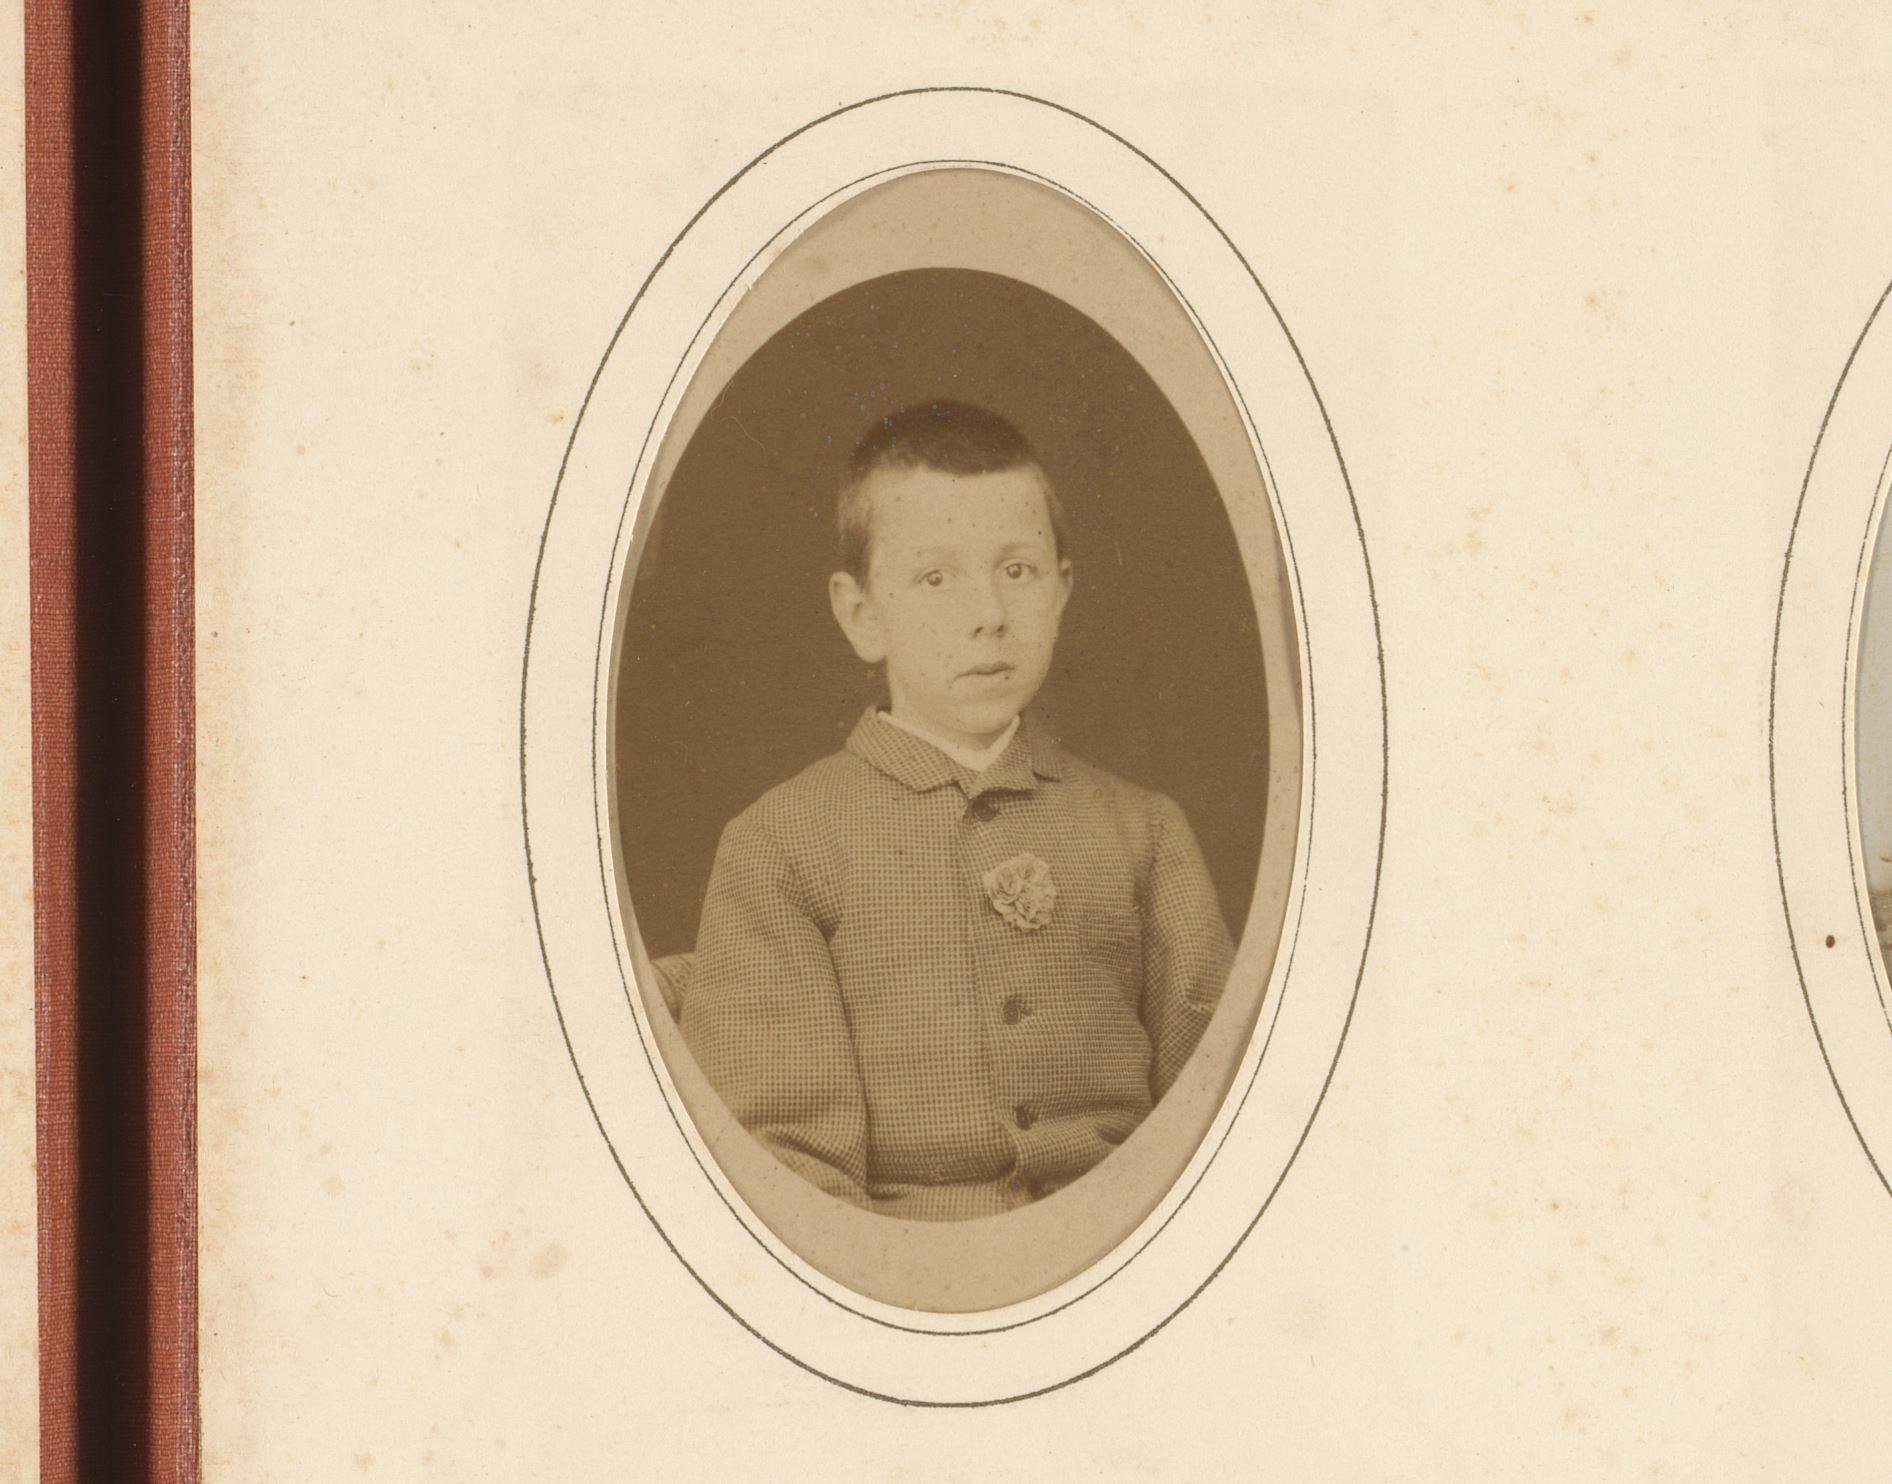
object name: photograph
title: Portret van een jongen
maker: lodewijk hendrikus serré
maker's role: fotograaf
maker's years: 1847-1897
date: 1877-1897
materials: cardboard, photographic support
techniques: albumen print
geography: utrecht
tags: boy (child between toddler and youth), historical persons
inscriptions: inscription: ‘L. H. SERRÉ/ PHOTOGRAPHE/ NACHTEGAALSTRAAT over het Park Tivoli/ Utrecht/ 's Hage, Tiel en Schoonhoven./ Voor nabestelling blÿft de plaat bewaard.’